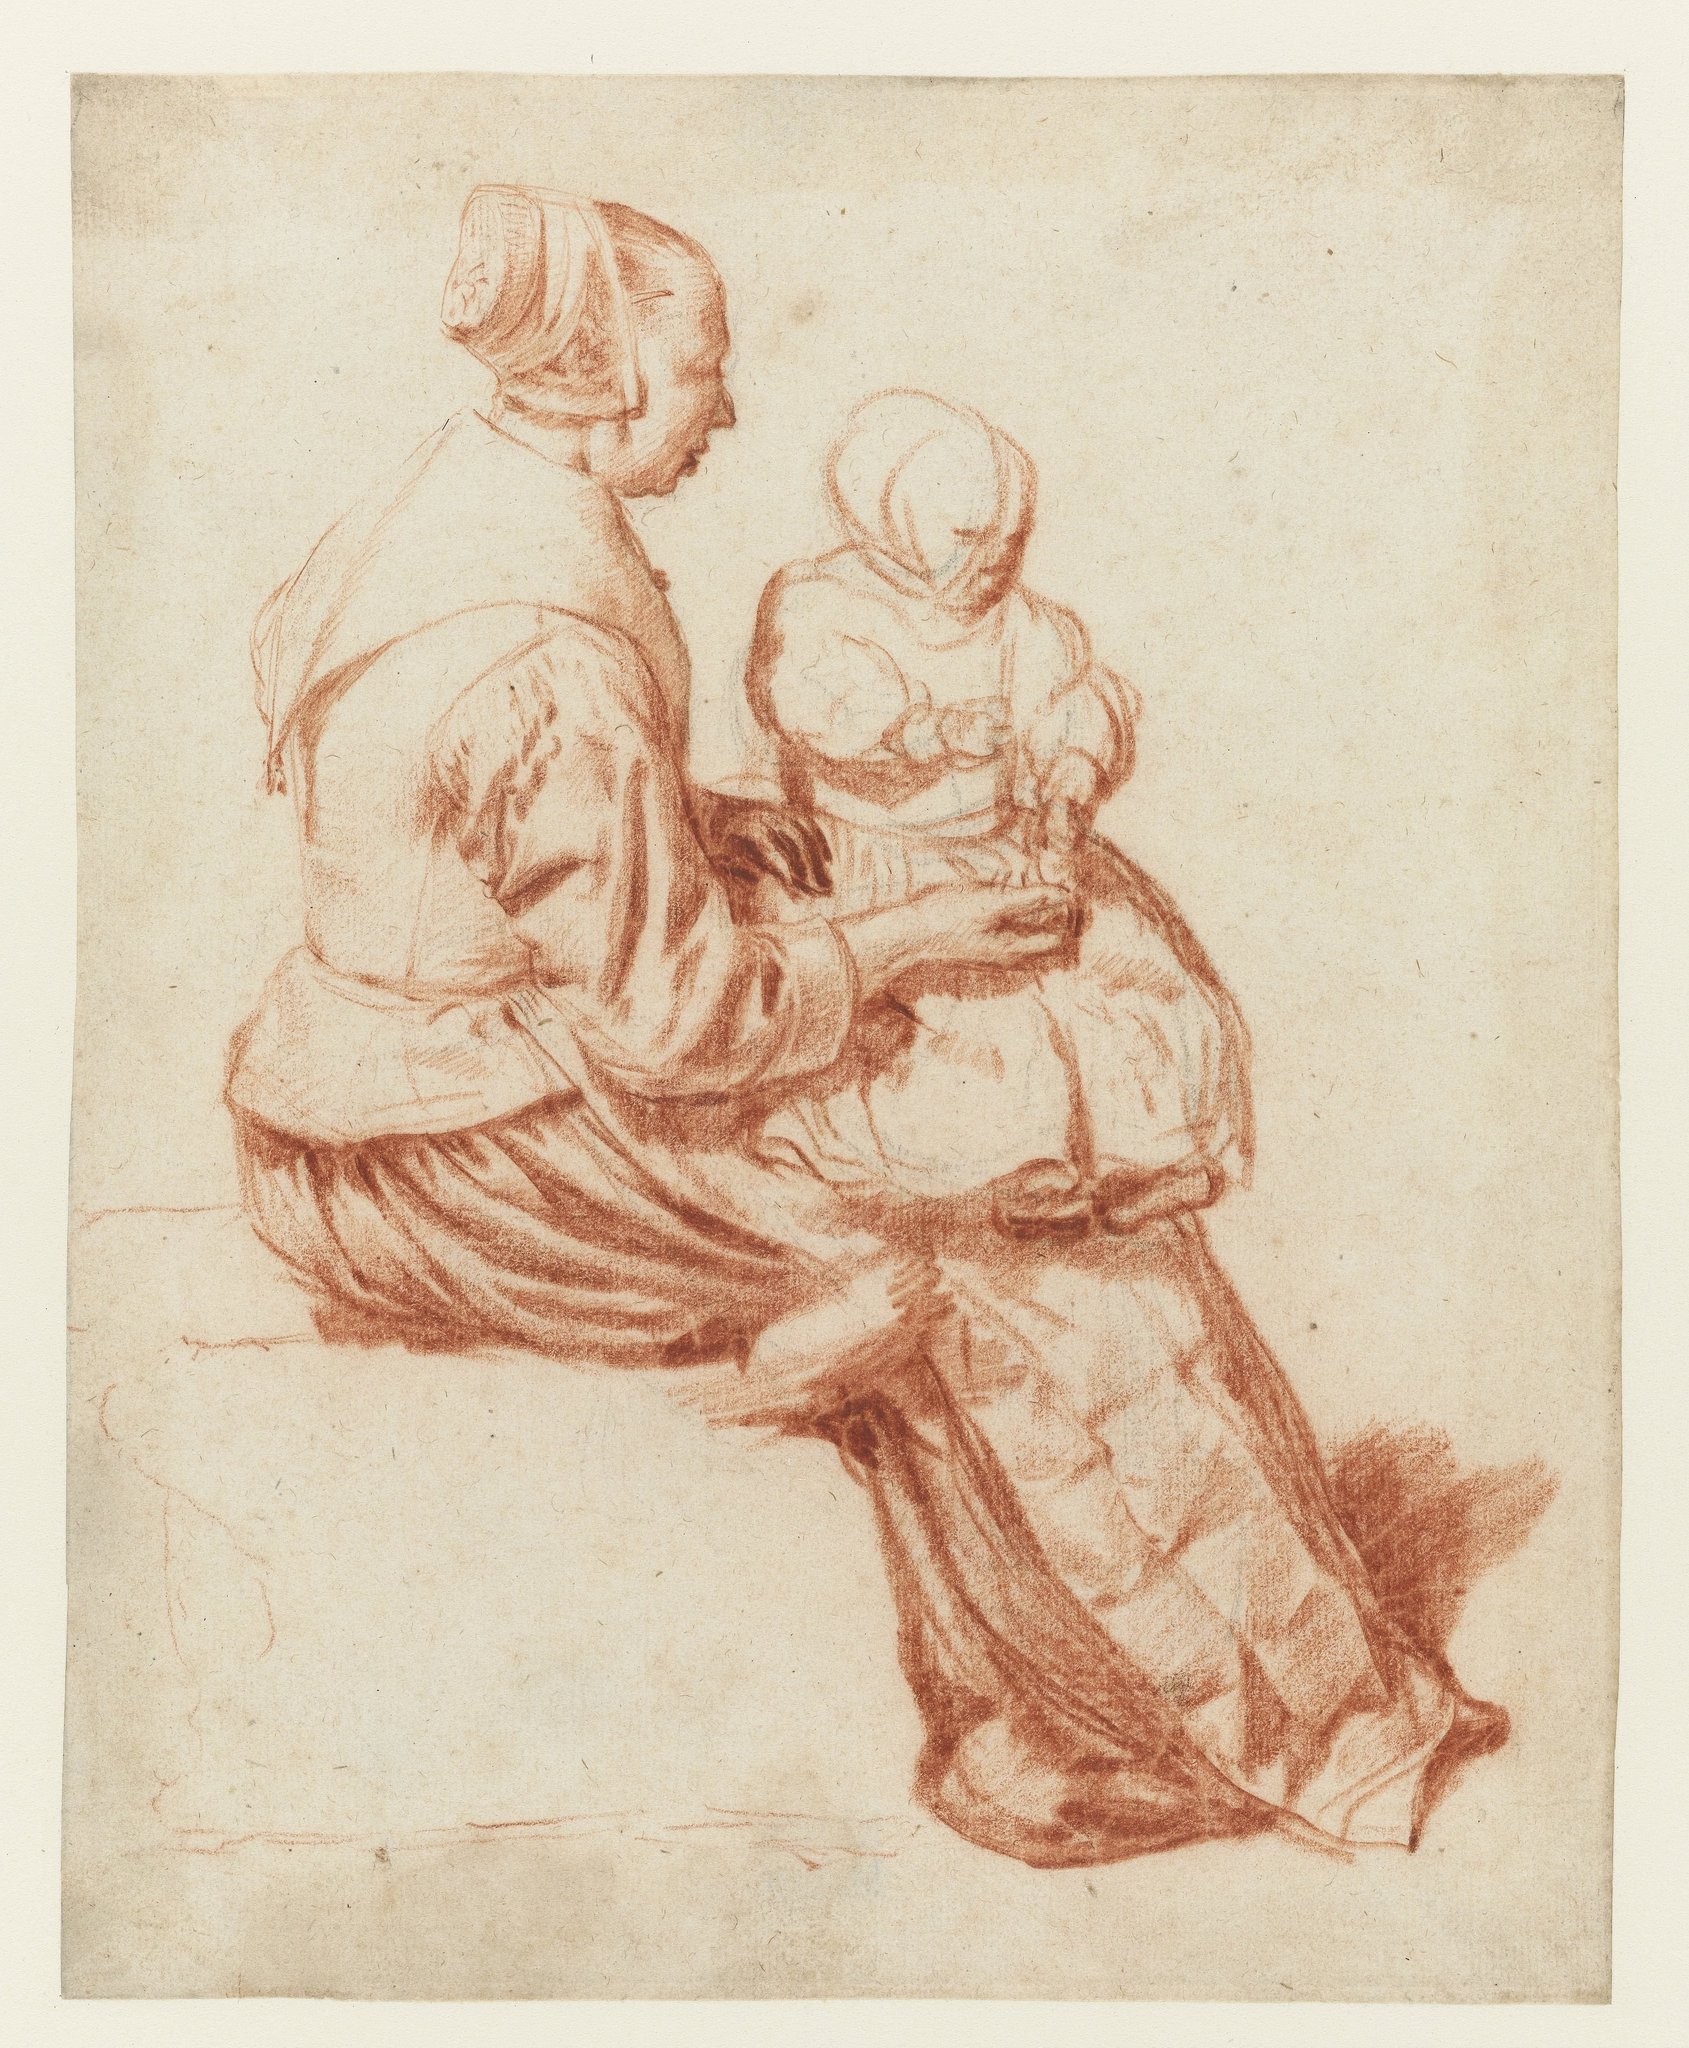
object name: drawing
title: Sitting Woman with a Child on her Lap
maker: adriaen van de velde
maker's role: draughtsman, painter, print maker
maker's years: 1636-1672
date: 1662-1667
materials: chalk, paper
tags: sitting figure - aa - female human figure, child, mother and baby or young child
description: In so far as is known this is the only preserved preparatory study for the large family portrait in a landscape. From the drawing, it is evident that Van de Velde initially wanted to depict the little girl with her face turned to the right. In the painting, she looks out directly at you.